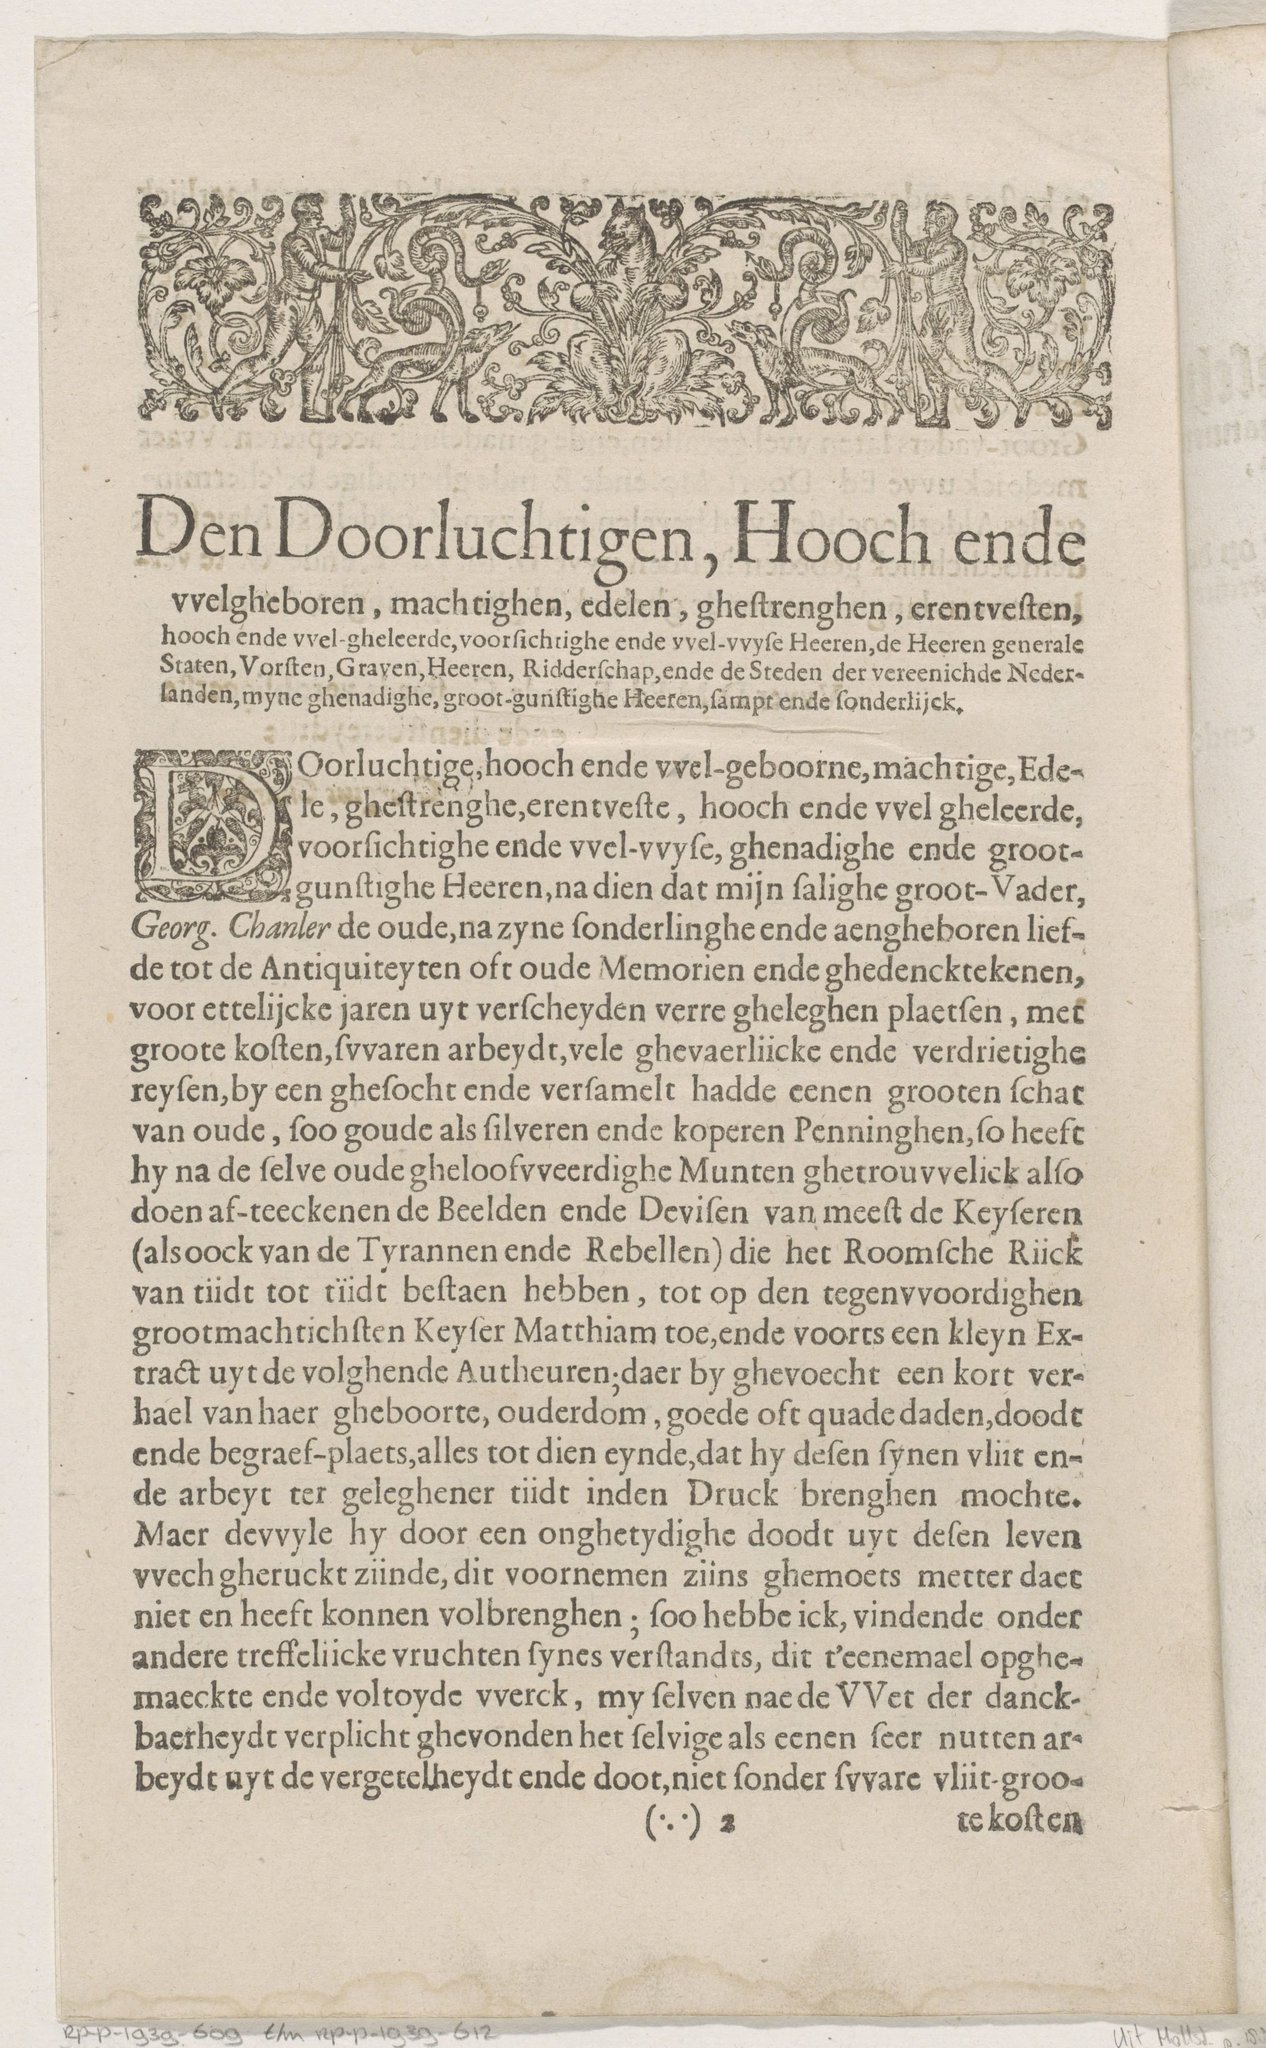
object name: book illustration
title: Ornamenten met planten, dieren en figuren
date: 1617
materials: paper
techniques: letterpress printing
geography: amsterdam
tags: ornaments ~ art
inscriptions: collector's mark: Lugt 2760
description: Prent uit: Georgius Chanler. Nieuwe keysers chronica ofte Gheschicht-boeck van alle de roomsche, soo oostersche als westersche keyseren. Amsterdam: Nicolaes Biestkens, 1617.